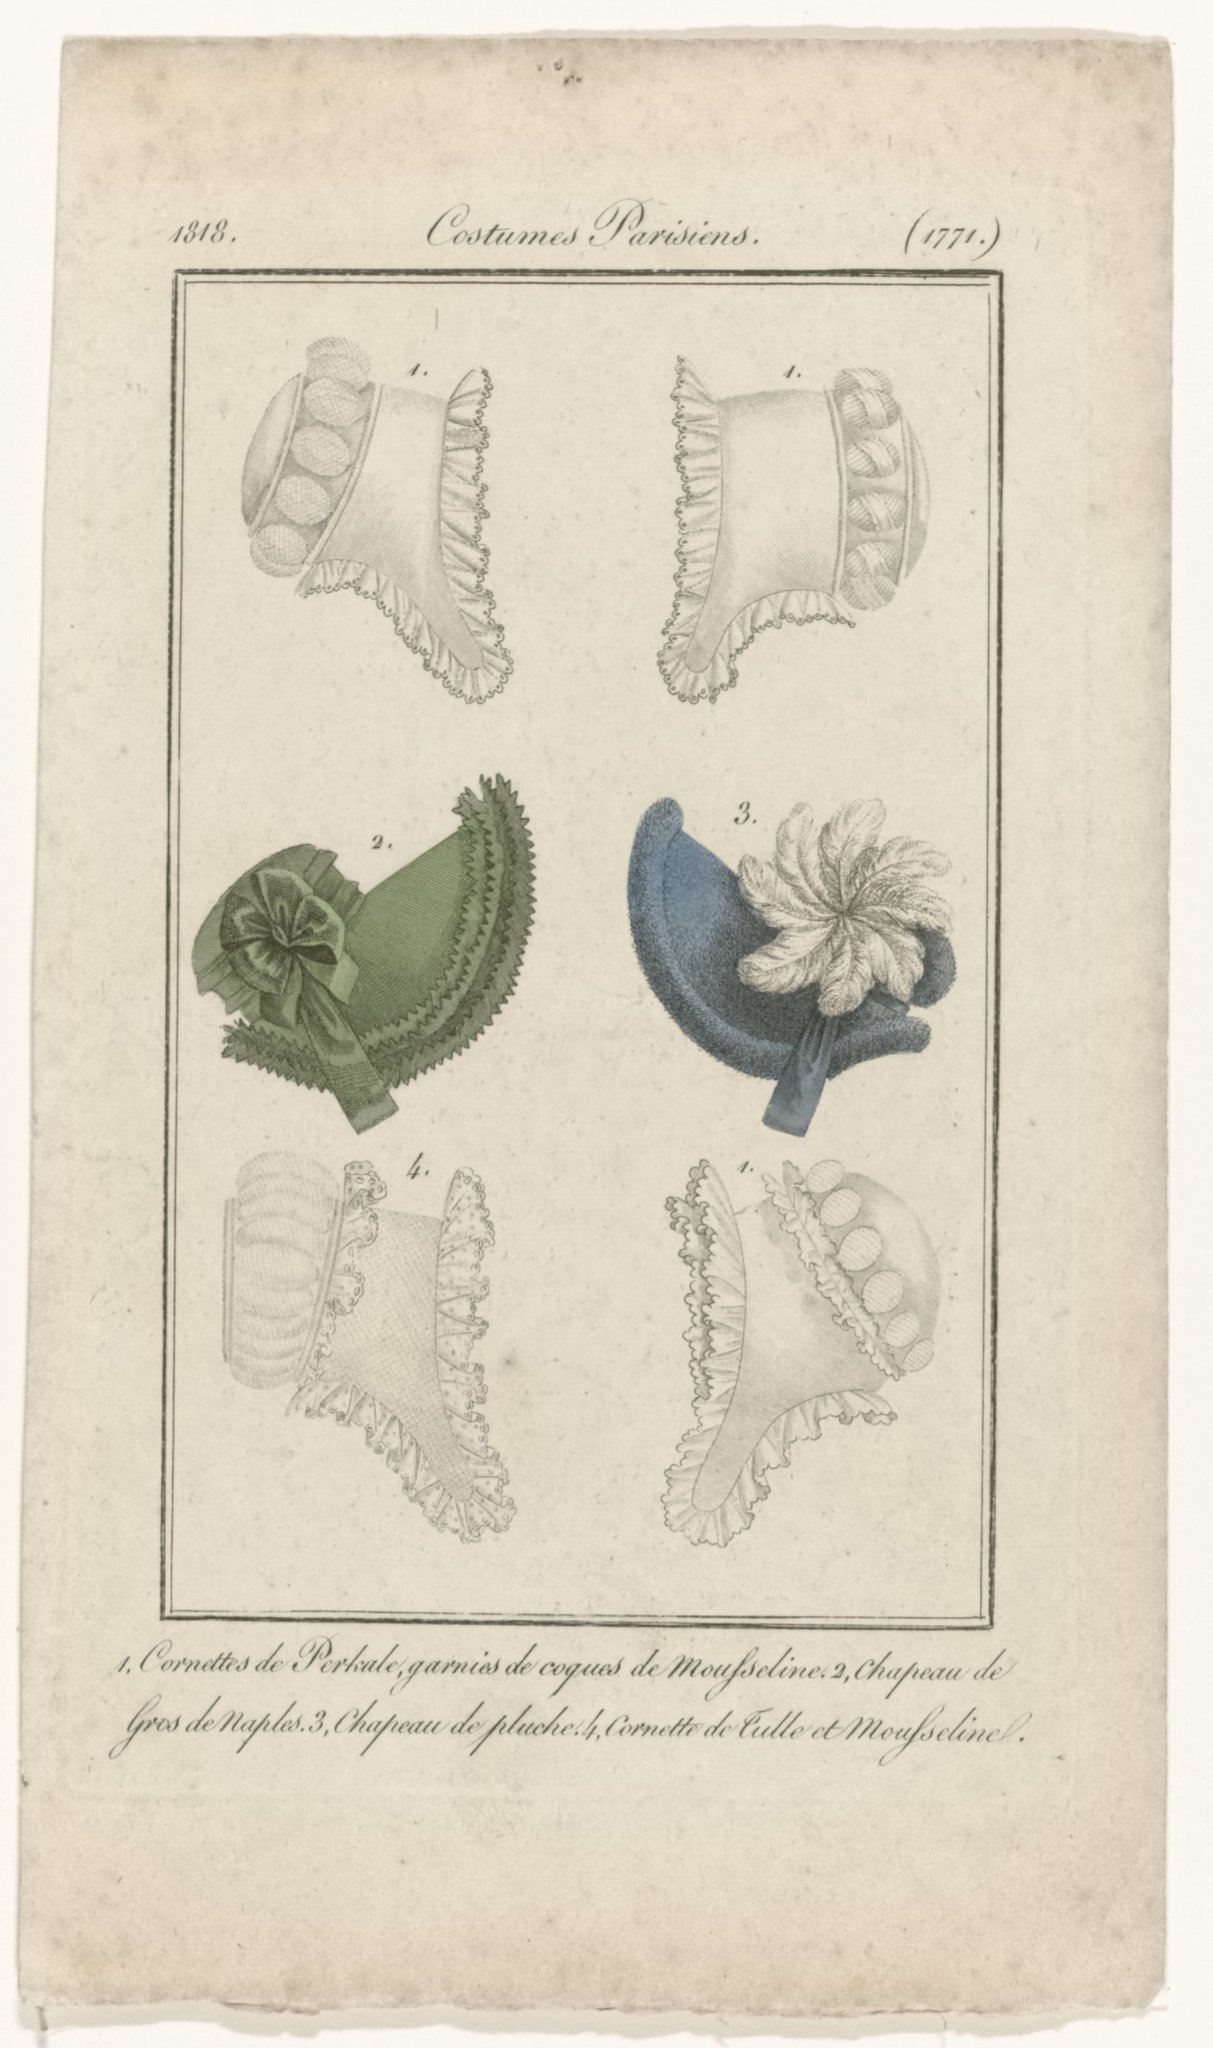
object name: fashion print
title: Journal des Dames et des Modes, Costumes Parisiens, 5 novembre 1818, (1771): 1. Cornettes de Perkale (...)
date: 1818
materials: paper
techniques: engraving, hand coloring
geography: paris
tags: head-gear (cornette) (+ women's clothes), fashion plates, head-gear: hat (+ women's clothes)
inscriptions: caption: ‘1. Cornettes de Perkale, garnies de coques de Mousseline. 2, Chapeau de Gros de Naples. 3, Chapeau de pluche. 4, Cornette de Tulle et Mousseline.’, title: ‘Costumes Parisiens.’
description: Zes verschillende hoeden en mutsen in één kader, genummerd één tot en met vier. 1. 'Cornettes' van katoenbatist (percale) gegarneerd met 'coques' van mousseline. 2. Hoed van 'gros de Naples'. 3. Hoed van pluche. 4. 'Cornette' van tule en Mousseline. De prent maakt deel uit van het modetijdschrift Journal des Dames et des Modes, uitgegeven door Pierre de la Mésangère, Parijs, 1797-1839.